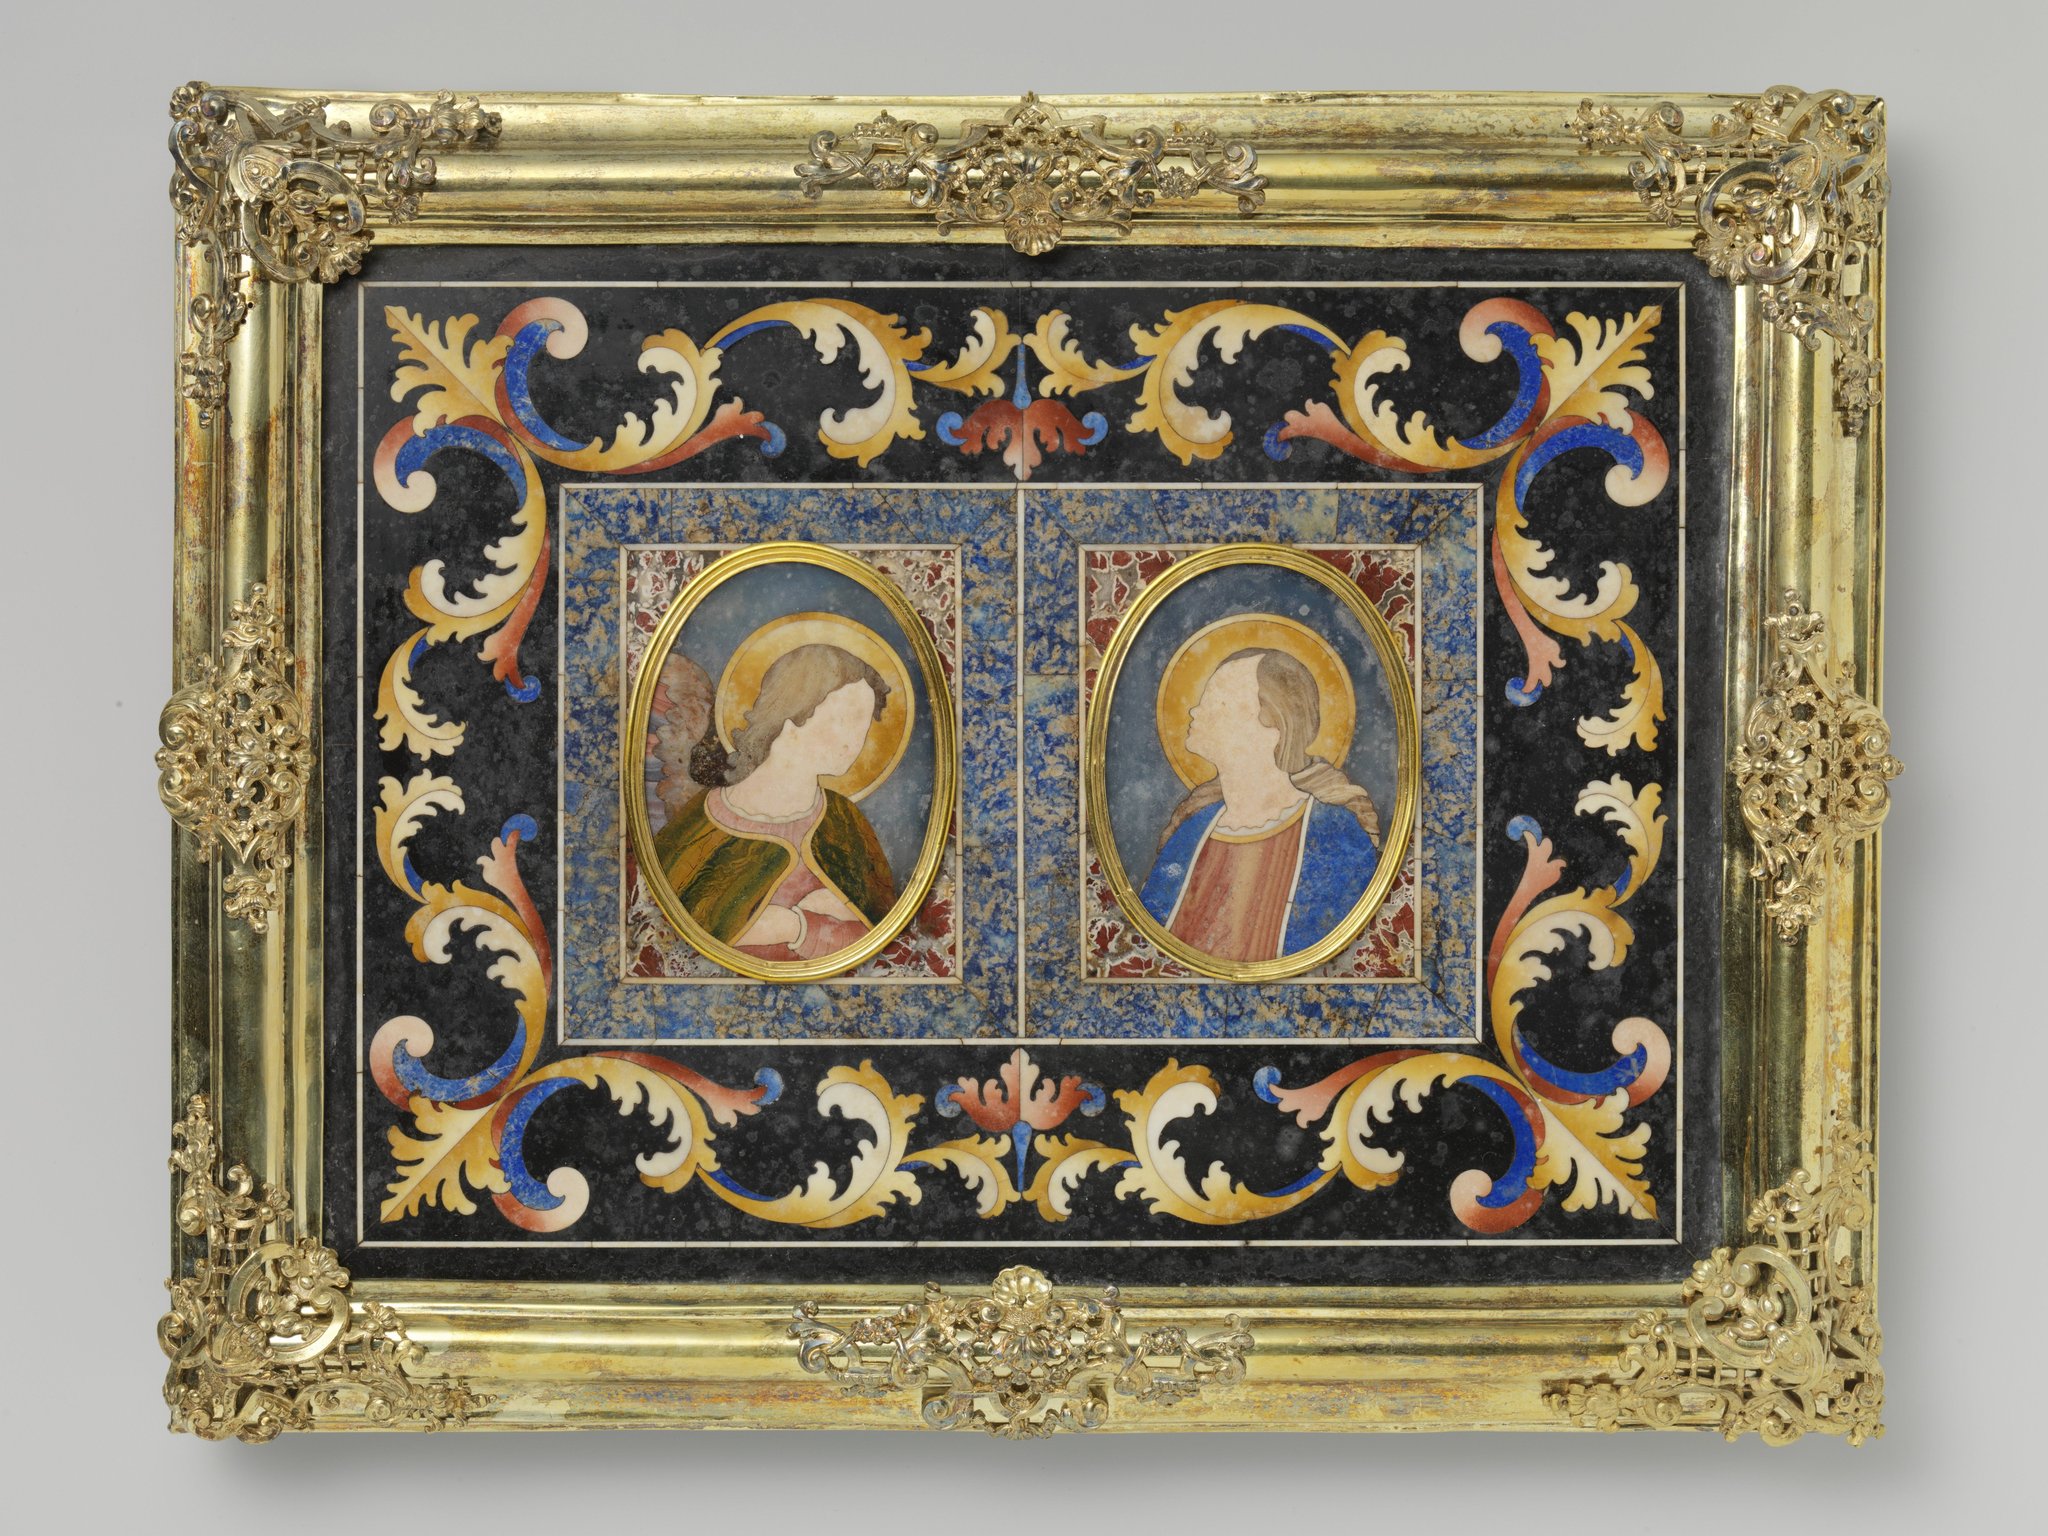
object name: plaque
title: Plaquette van pietre dure, voorstellende de Annunciatie in twee ovale velden met verguld koperen lijsten, omgeven door gestileerde bladranken, in verguld zilveren lijst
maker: joachim siegismund wiedemann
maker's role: silversmith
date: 1710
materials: copper, silver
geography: florence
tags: the annunciation: mary, usually reading, is visited by the angel (sometimes a woman overhears the conversation)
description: Plaque showing the Annunciation. Pietre dure in a silver gilt frame. Florence, c. 1710, Opificio delle pietre dure. The frame Berlin, c. 1715 - 1720, by Joachim Siegismund Wiedemann.